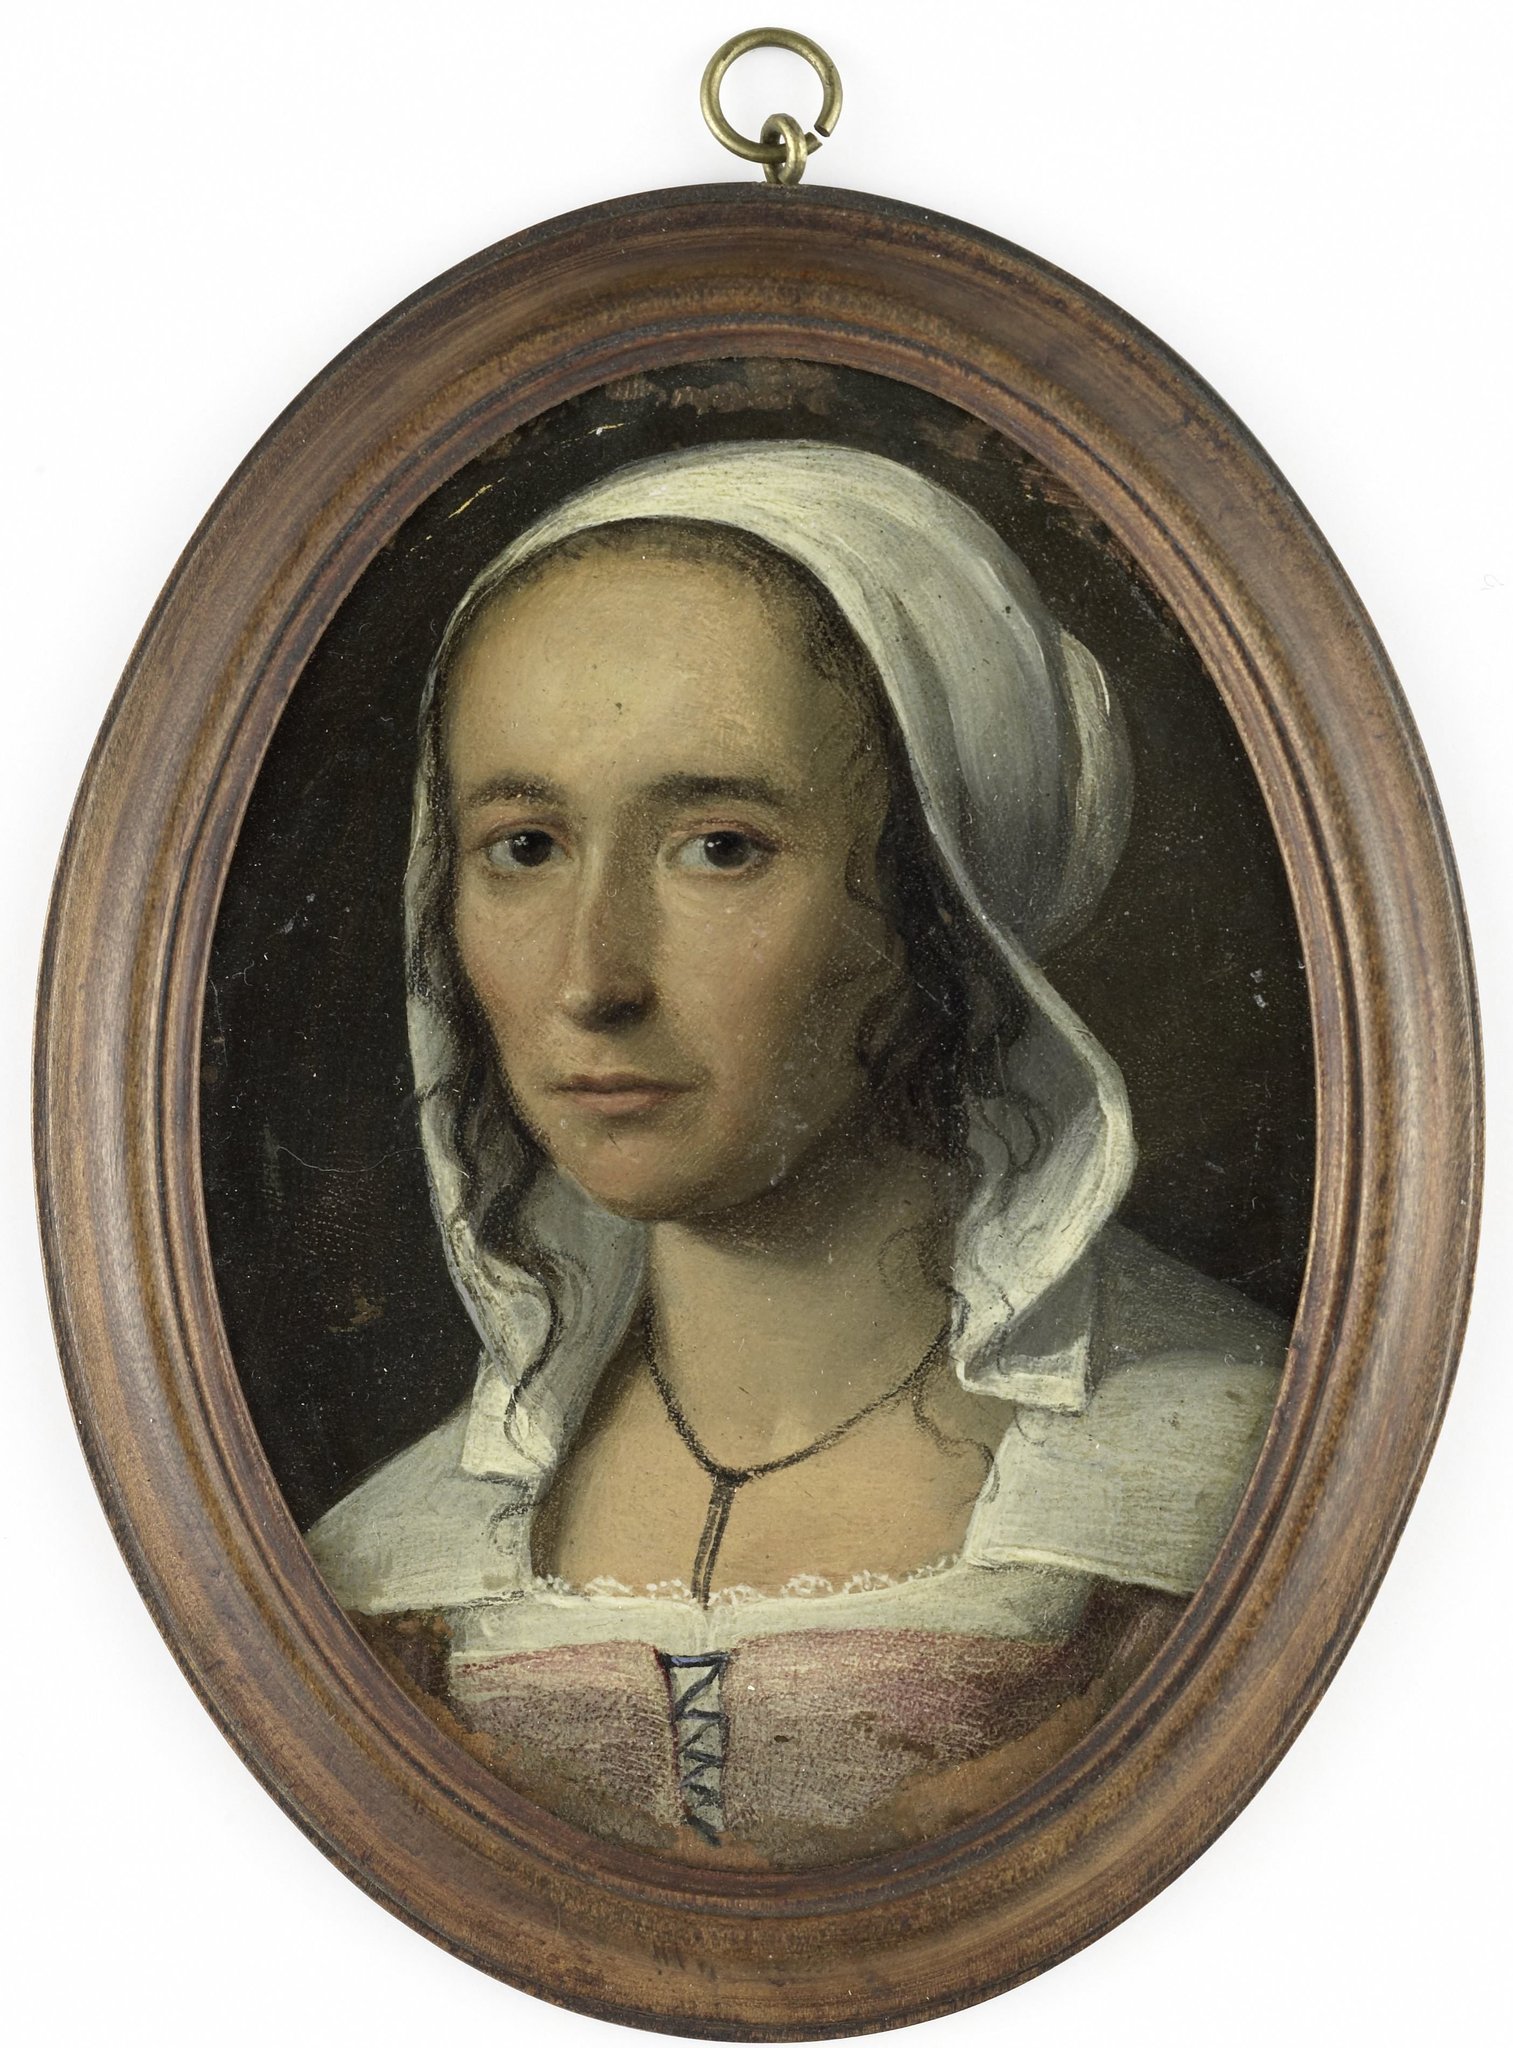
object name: painting, miniature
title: Portret van een vrouw, zogenaamd zelfportret van Anna Maria van Schurman (1607-78)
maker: Anonymous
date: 1645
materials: copper, oil, wood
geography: northern netherlands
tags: historical persons not known by name - bb - woman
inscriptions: inscription: ‘Marie Brughel peinte par son fils le Viuex en 1554 / Schuerman savante Utrecht, par elle même’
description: Portret van een vrouw, zogenaamd zelfportret van Anna Maria van Schurman (1607-78). Buste, naar links, de beschouwer aanziend, met een witte hoofddoek. Onderdeel van de collectie portretminiaturen.